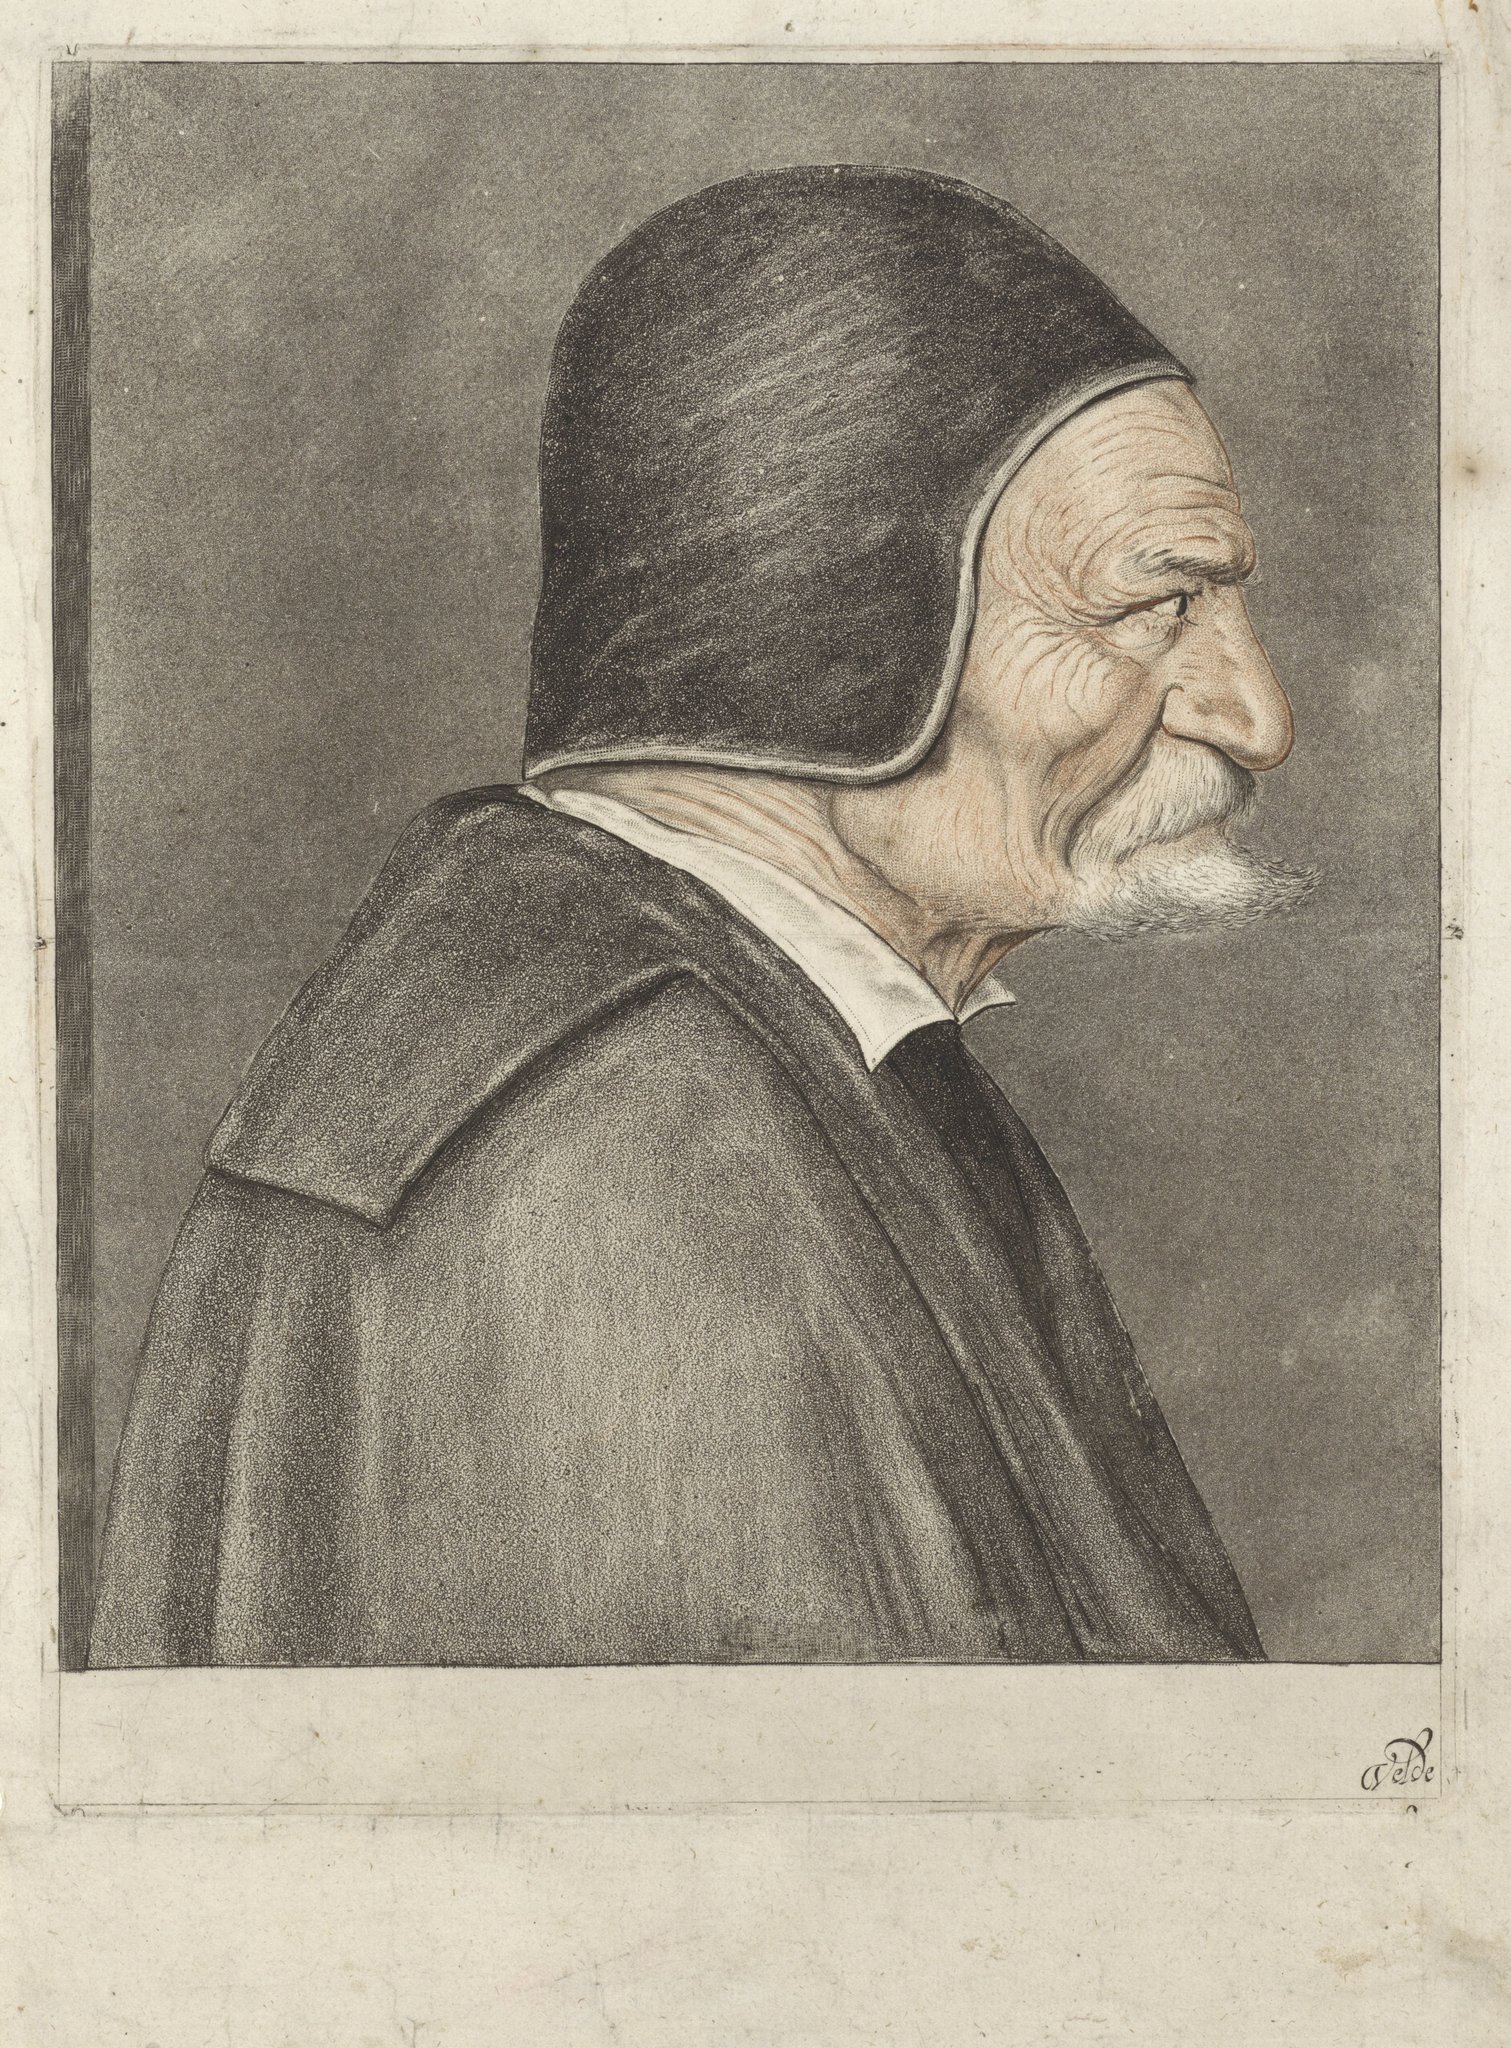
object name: print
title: Buste van een oude man, naar rechts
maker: nicolas lagneau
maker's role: draughtsman, painter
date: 1630-1686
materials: paper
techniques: etching, roulette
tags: old man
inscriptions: collector's mark: Lugt 2760, collector's mark: Lugt 2228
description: Onbeschreven watermerk vgl. Briquet 940 c. 1580-1617.